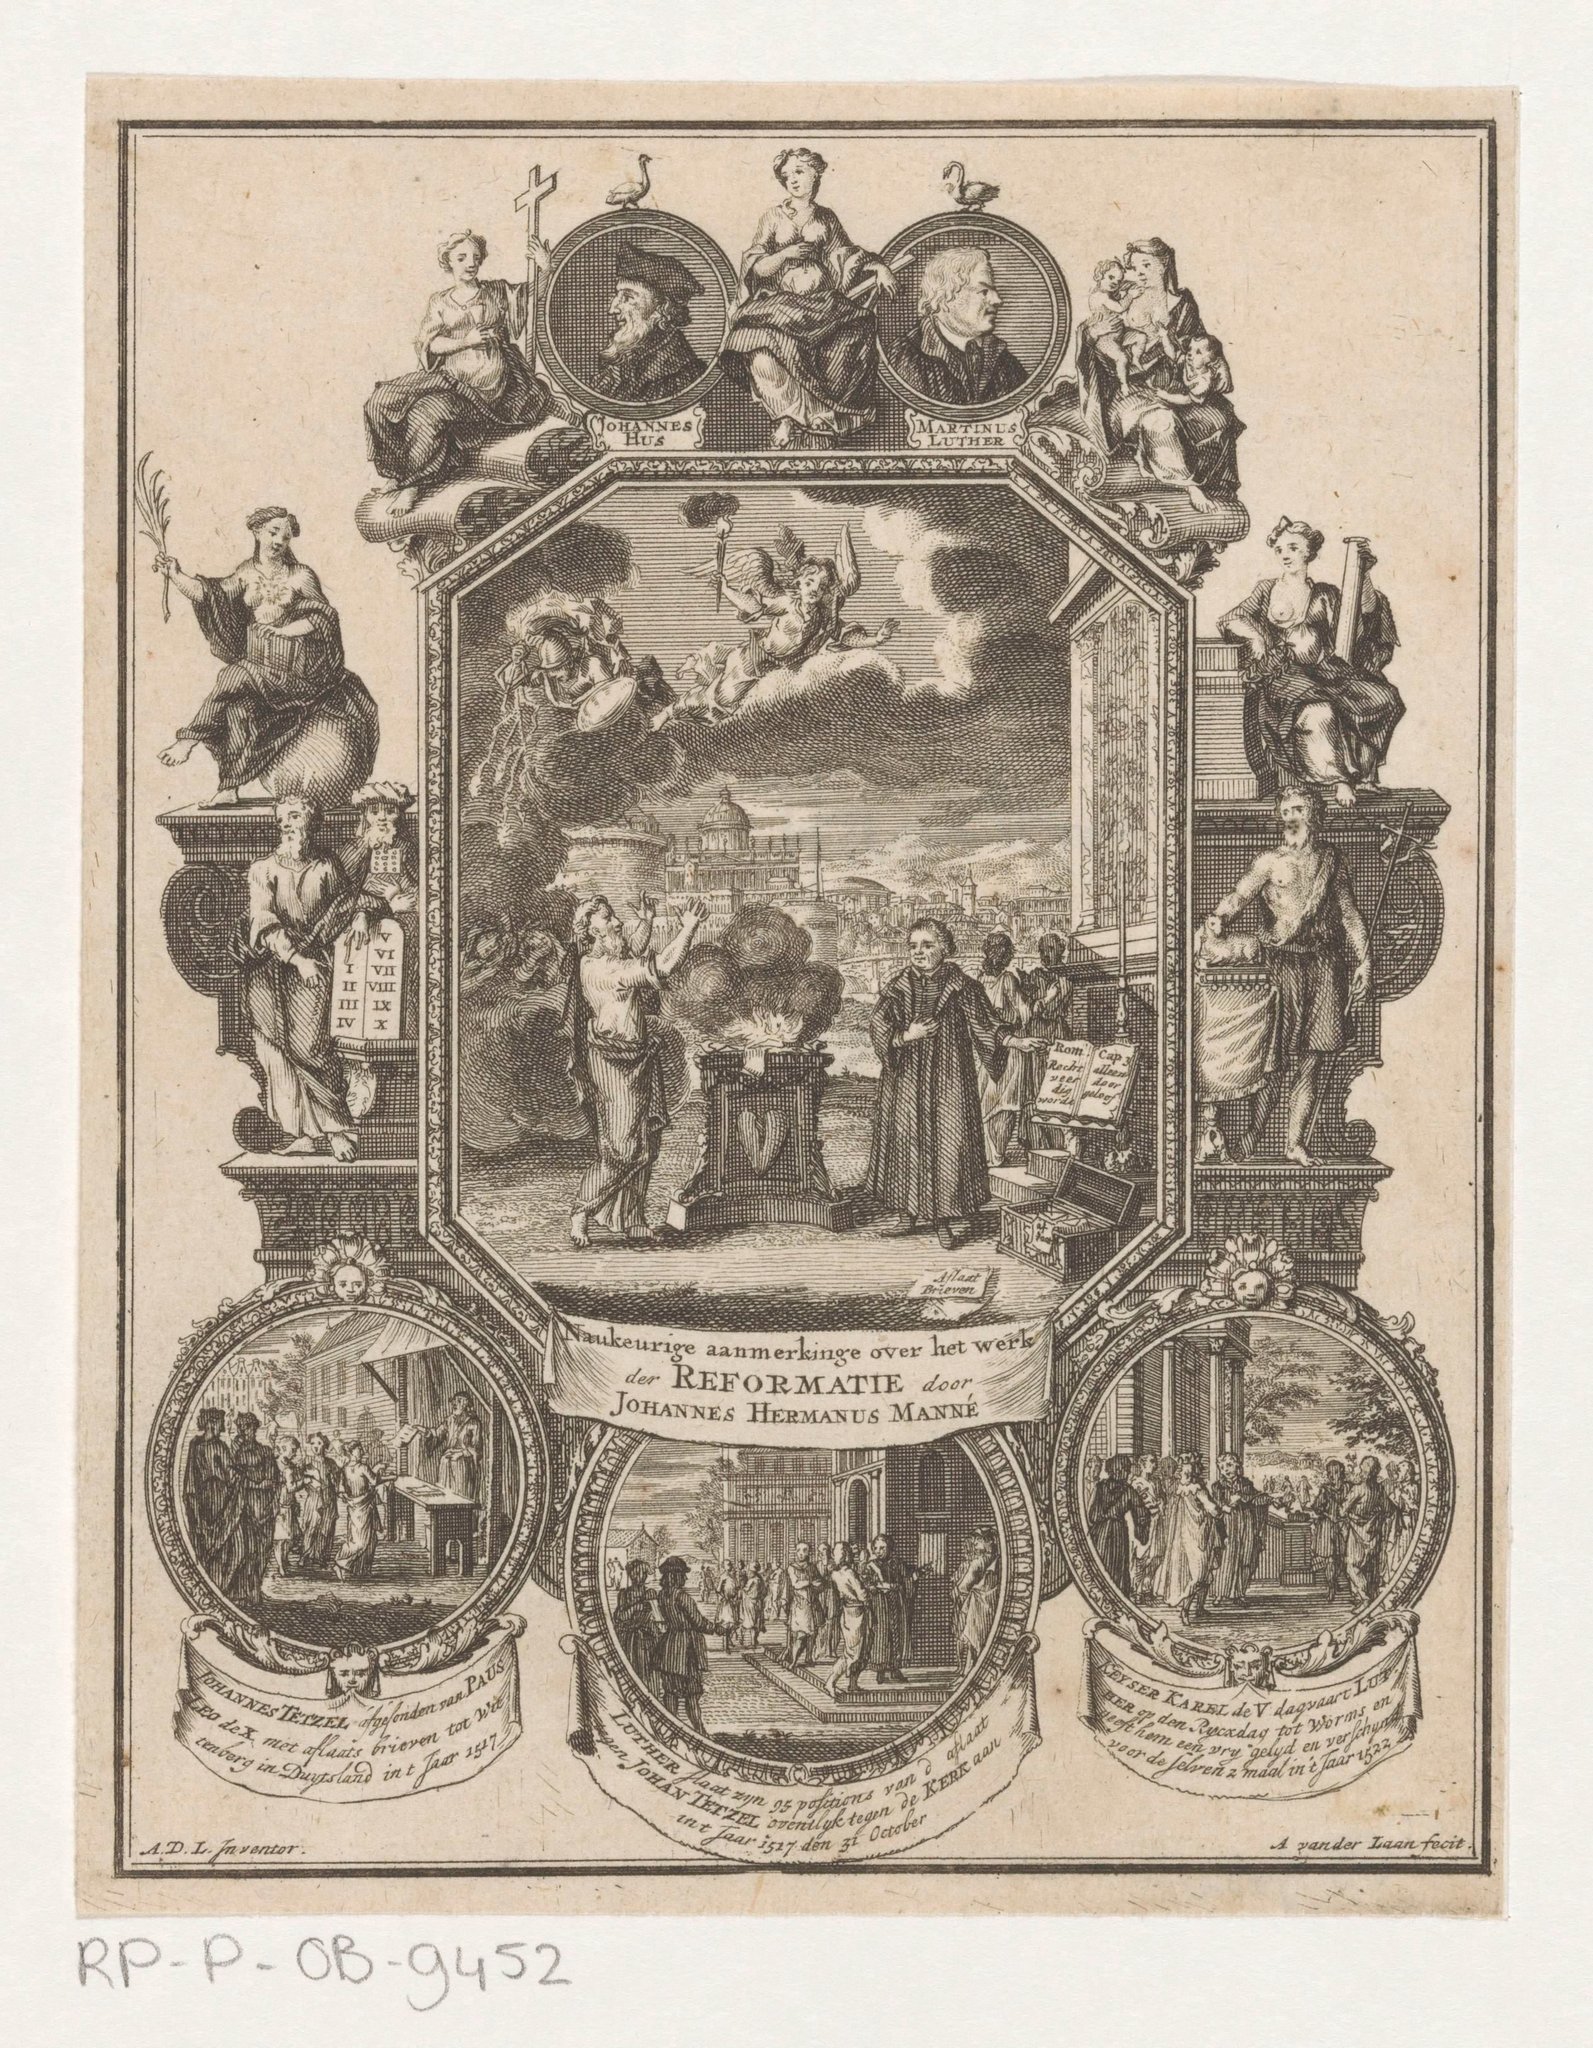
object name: titelblad, titelpagina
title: Titelpagina voor: Johannes Hermanus Manné, Nauwkeurige zo theologise als historise aanmerkingen over het werk der reformatie, 1719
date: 1719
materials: paper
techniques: etching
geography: haarlem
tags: martin luther, 'confessio augustana', 'augsburger konfession', (story of) jupiter (zeus)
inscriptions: collector's mark: Lugt 2760, collector's mark: Lugt 2228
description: Allegorie op het tweede eeuwfeest van de Hervorming in een architecturale omlijsting, versierd met allegorische figuren en portretmedaillons van Luther en Hus. Allegorische voorstelling met de hervormers Luther en Melanthon bij een altaar, in de verte ligt de Sint Pieterskerk. In de lucht vliegt een engel met brandende toorts, naast haar is Jupiter met bliksemschichten verschenen. Hieronder drie historische voorstellingen in medaillon, voorzien van toelichtende teksten.